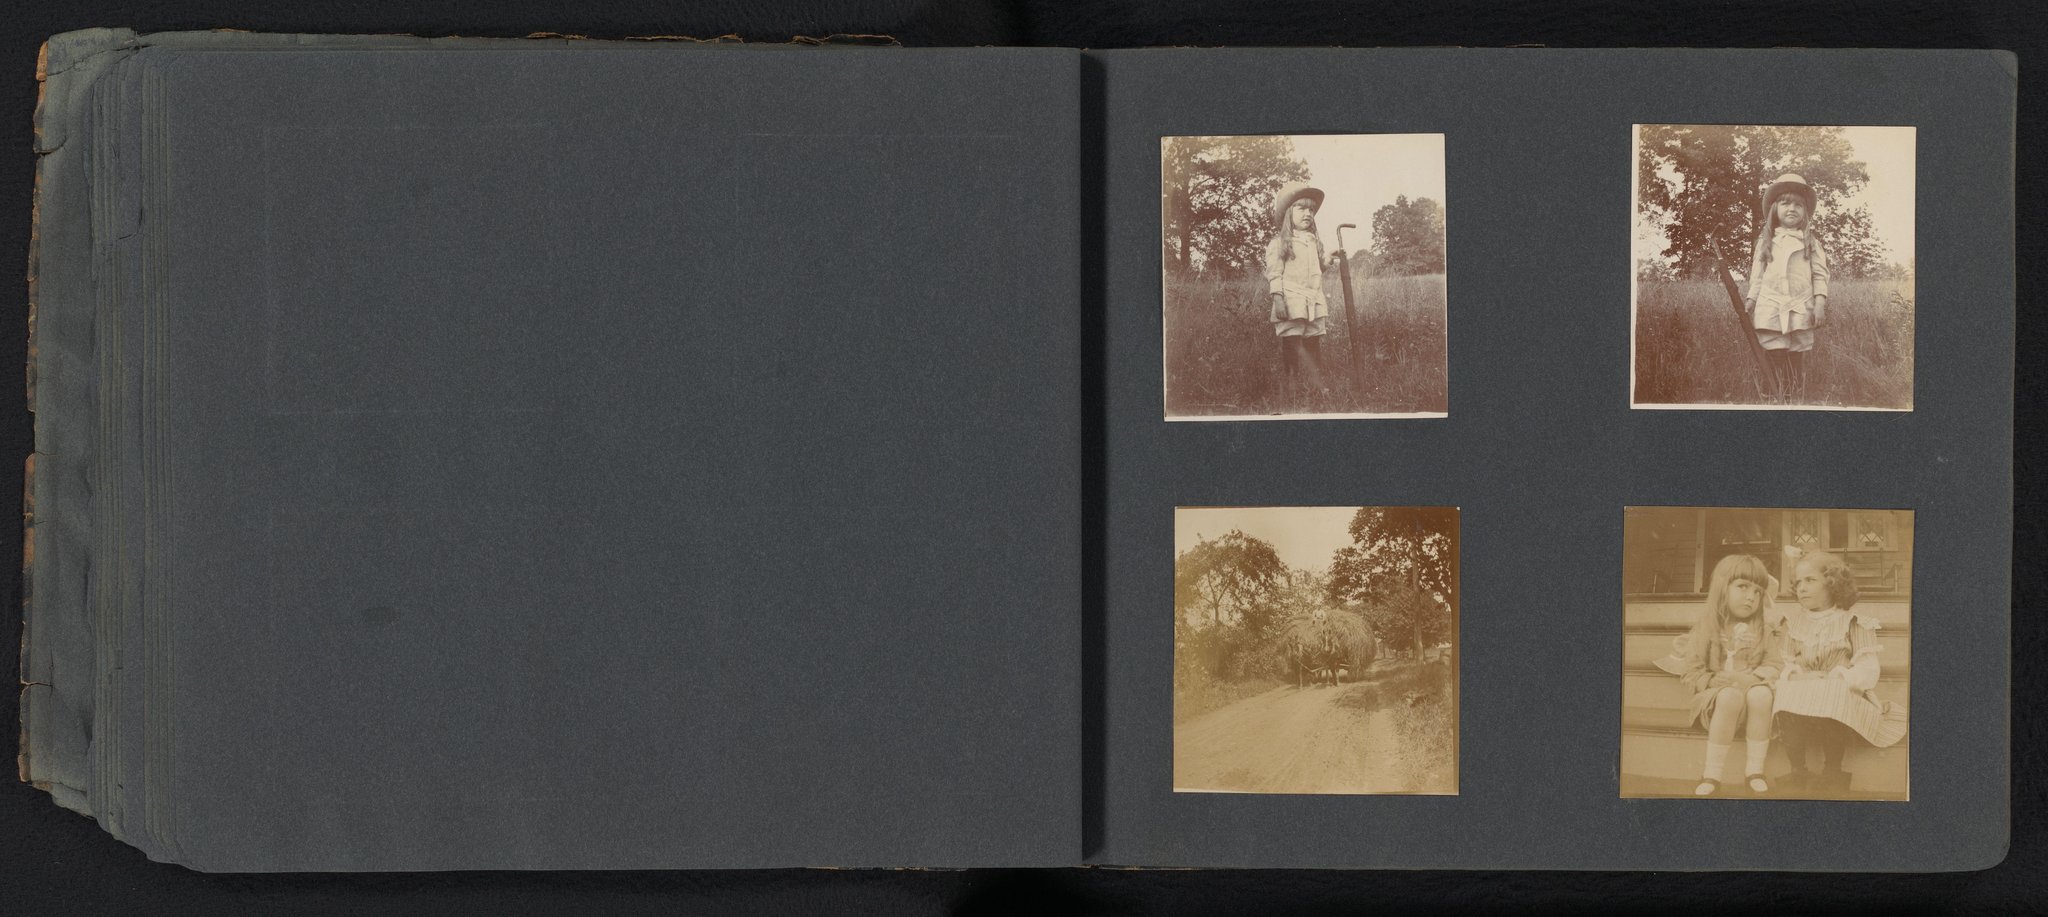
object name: photograph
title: Jonge meisjes en hooiwagen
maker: Anonymous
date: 1890-1902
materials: paper, photographic support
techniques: gelatin silver print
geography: united states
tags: clothing for the lower part of the body, child, historical persons, clothing for the upper part of the body, umbrella, hay-wagon, united states of america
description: Albumblad met twee foto's van een jong meisje staand in een tuin, van een hooiwagen met paarden op een landweg en van twee jonge meisjes zittend op een trap. Onderdeel van Familiealbum met voornamelijk foto's van een jong Amerikaans meisje.